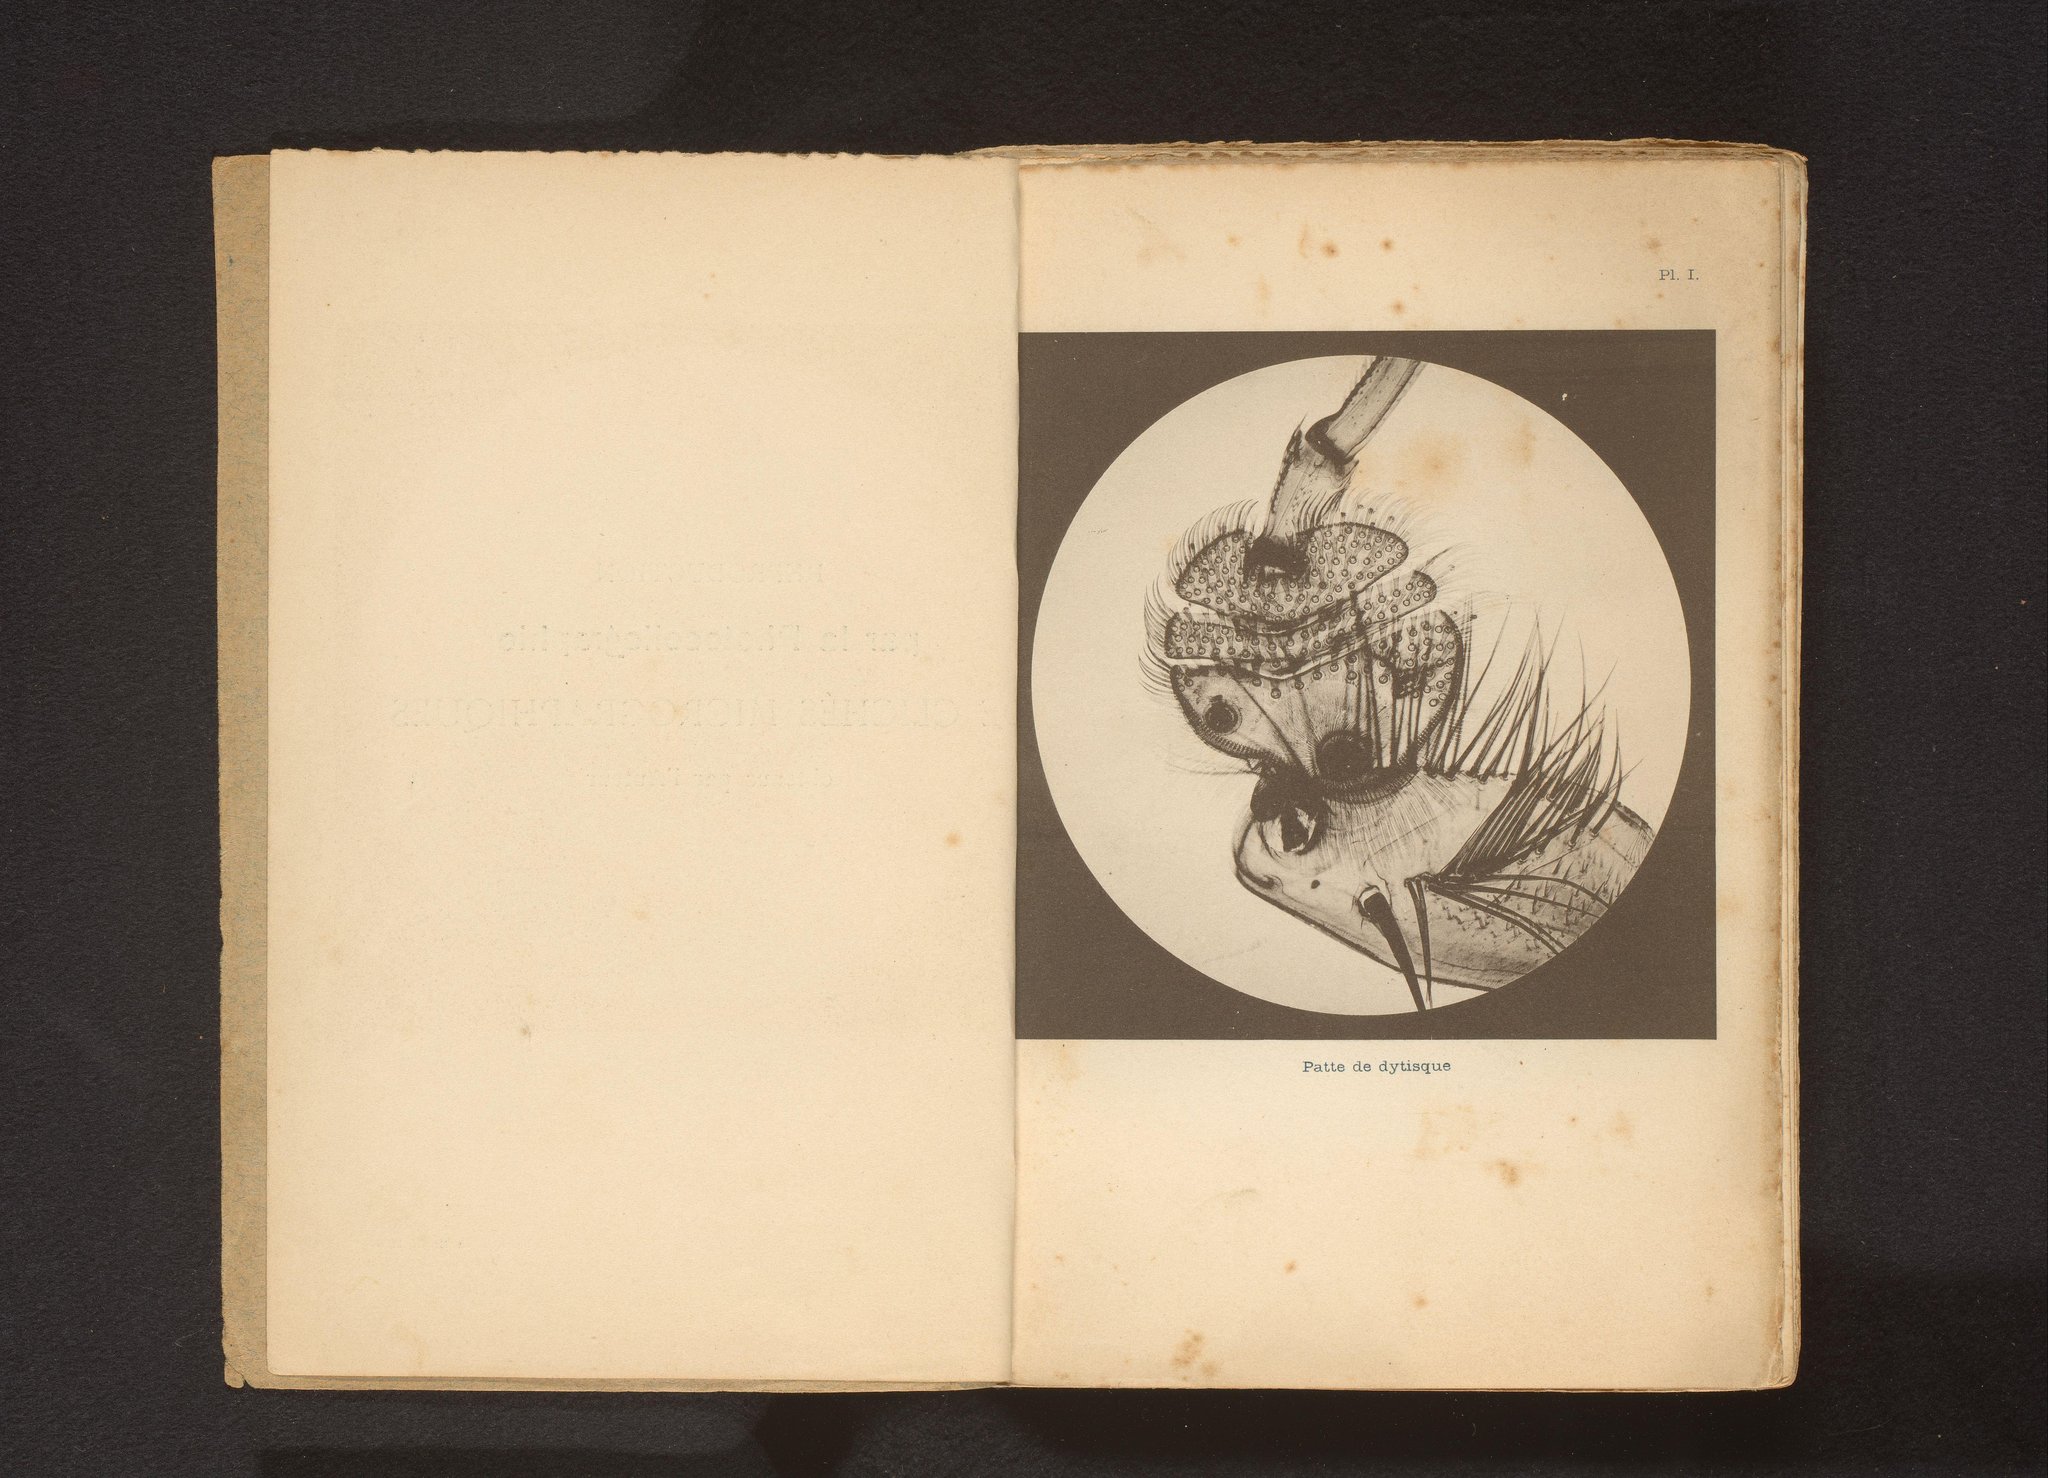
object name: photomechanical print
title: Microscoopopname van een poot van een waterroofkever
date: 1880-1899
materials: paper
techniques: photograph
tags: insects: beetle, microscope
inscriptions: number: ‘Pl. I.’